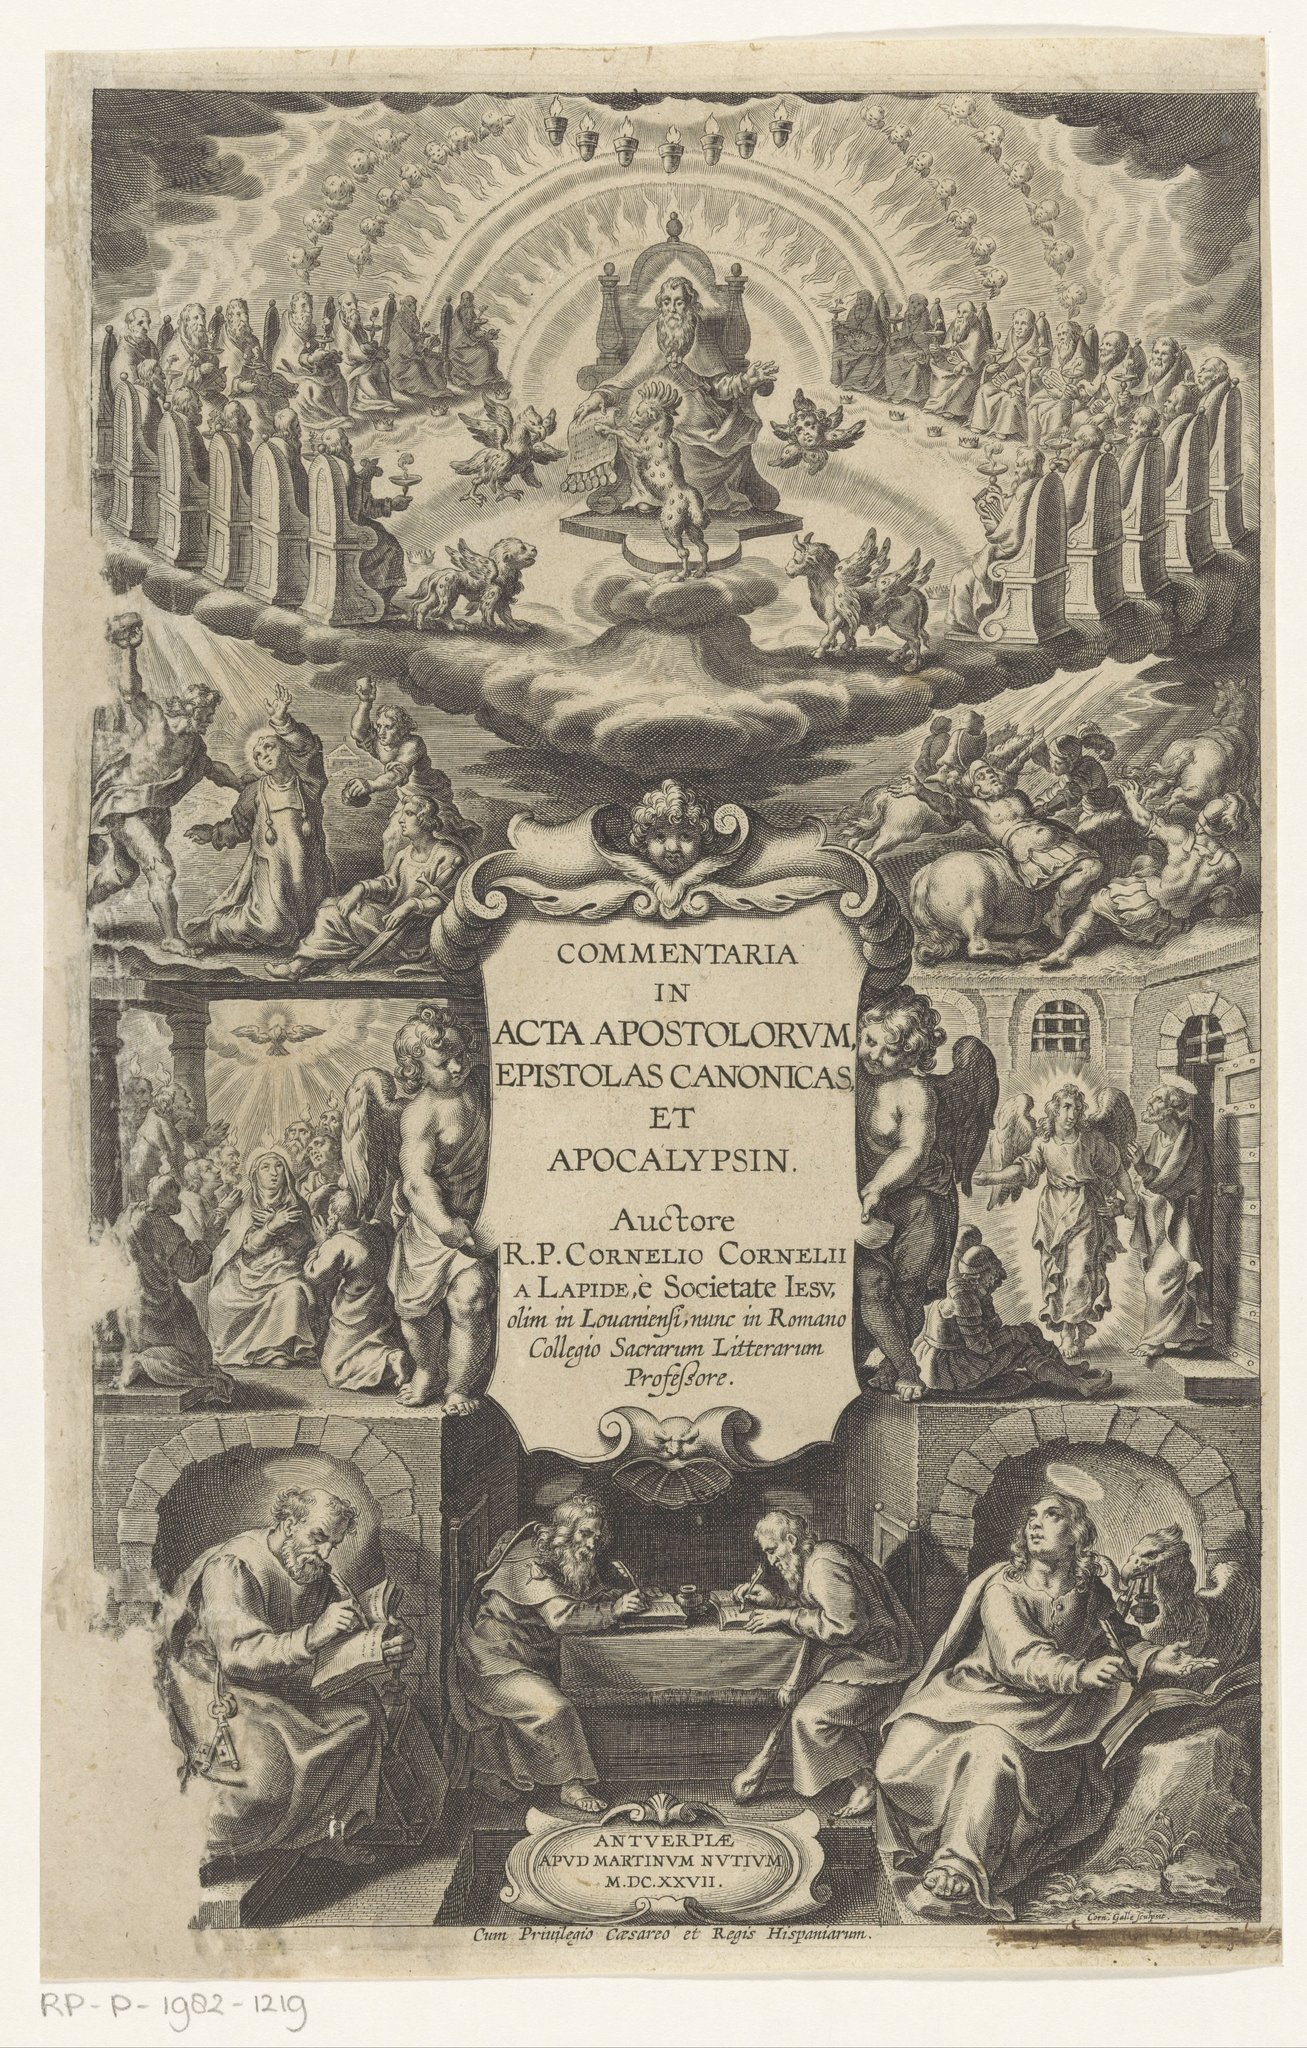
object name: print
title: God tronend, uitstorting van de Heilige Geest, bevrijding van Paulus en apostelen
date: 1627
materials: paper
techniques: engraving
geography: antwerp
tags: paul in prison, god on his throne, surrounded by the twenty-four elders (wearing crowns and playing harps) and the four beasts, other groups of apostles, pentecost: the holy ghost descends upon (mary and) the apostles, sometimes paul and/or representatives of the nations present (acts 2:1-4)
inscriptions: collector's mark: Lugt 2760, collector's mark: Lugt 2228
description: In het midden een cartouche met titel vastgehouden door twee putti. Daarboven God tronend, omringd door de wezens van de evangelisten, engelen en de vierentwintig oudsten. Links de uitstorting van de Heilige Geest. Rechts bevrijdt een engel Paulus uit de gevangenis. Aan de onderzijde de apostelen Petrus met sleutel, Jacobus de meerdere met schelp, Jacobus de minder met knots en Johannes met adelaar schrijvend in boeken.